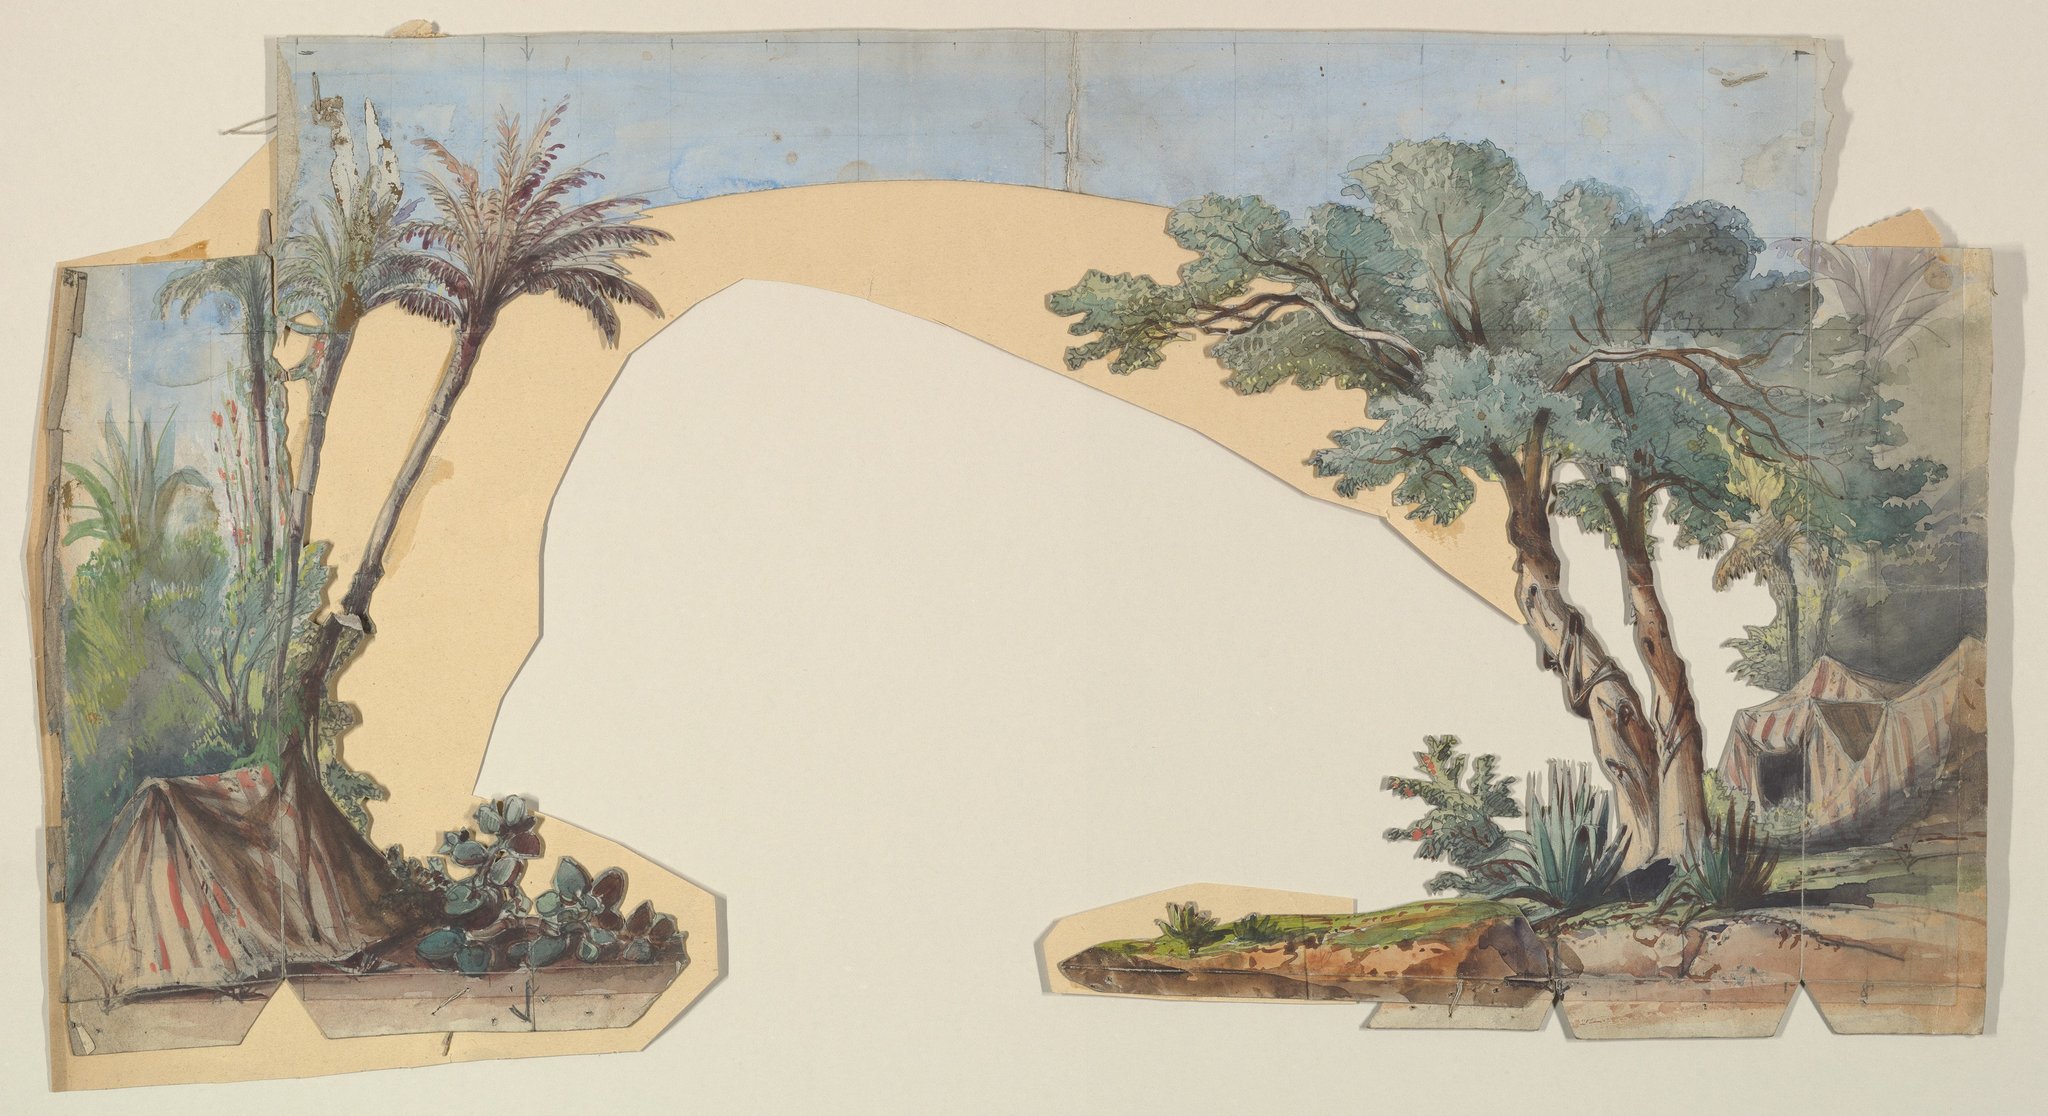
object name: drawing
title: Design for a Stage Set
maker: eugène cicéri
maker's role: artist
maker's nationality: french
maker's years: 1813-1890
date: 1830-1890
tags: tents,trees,stage design